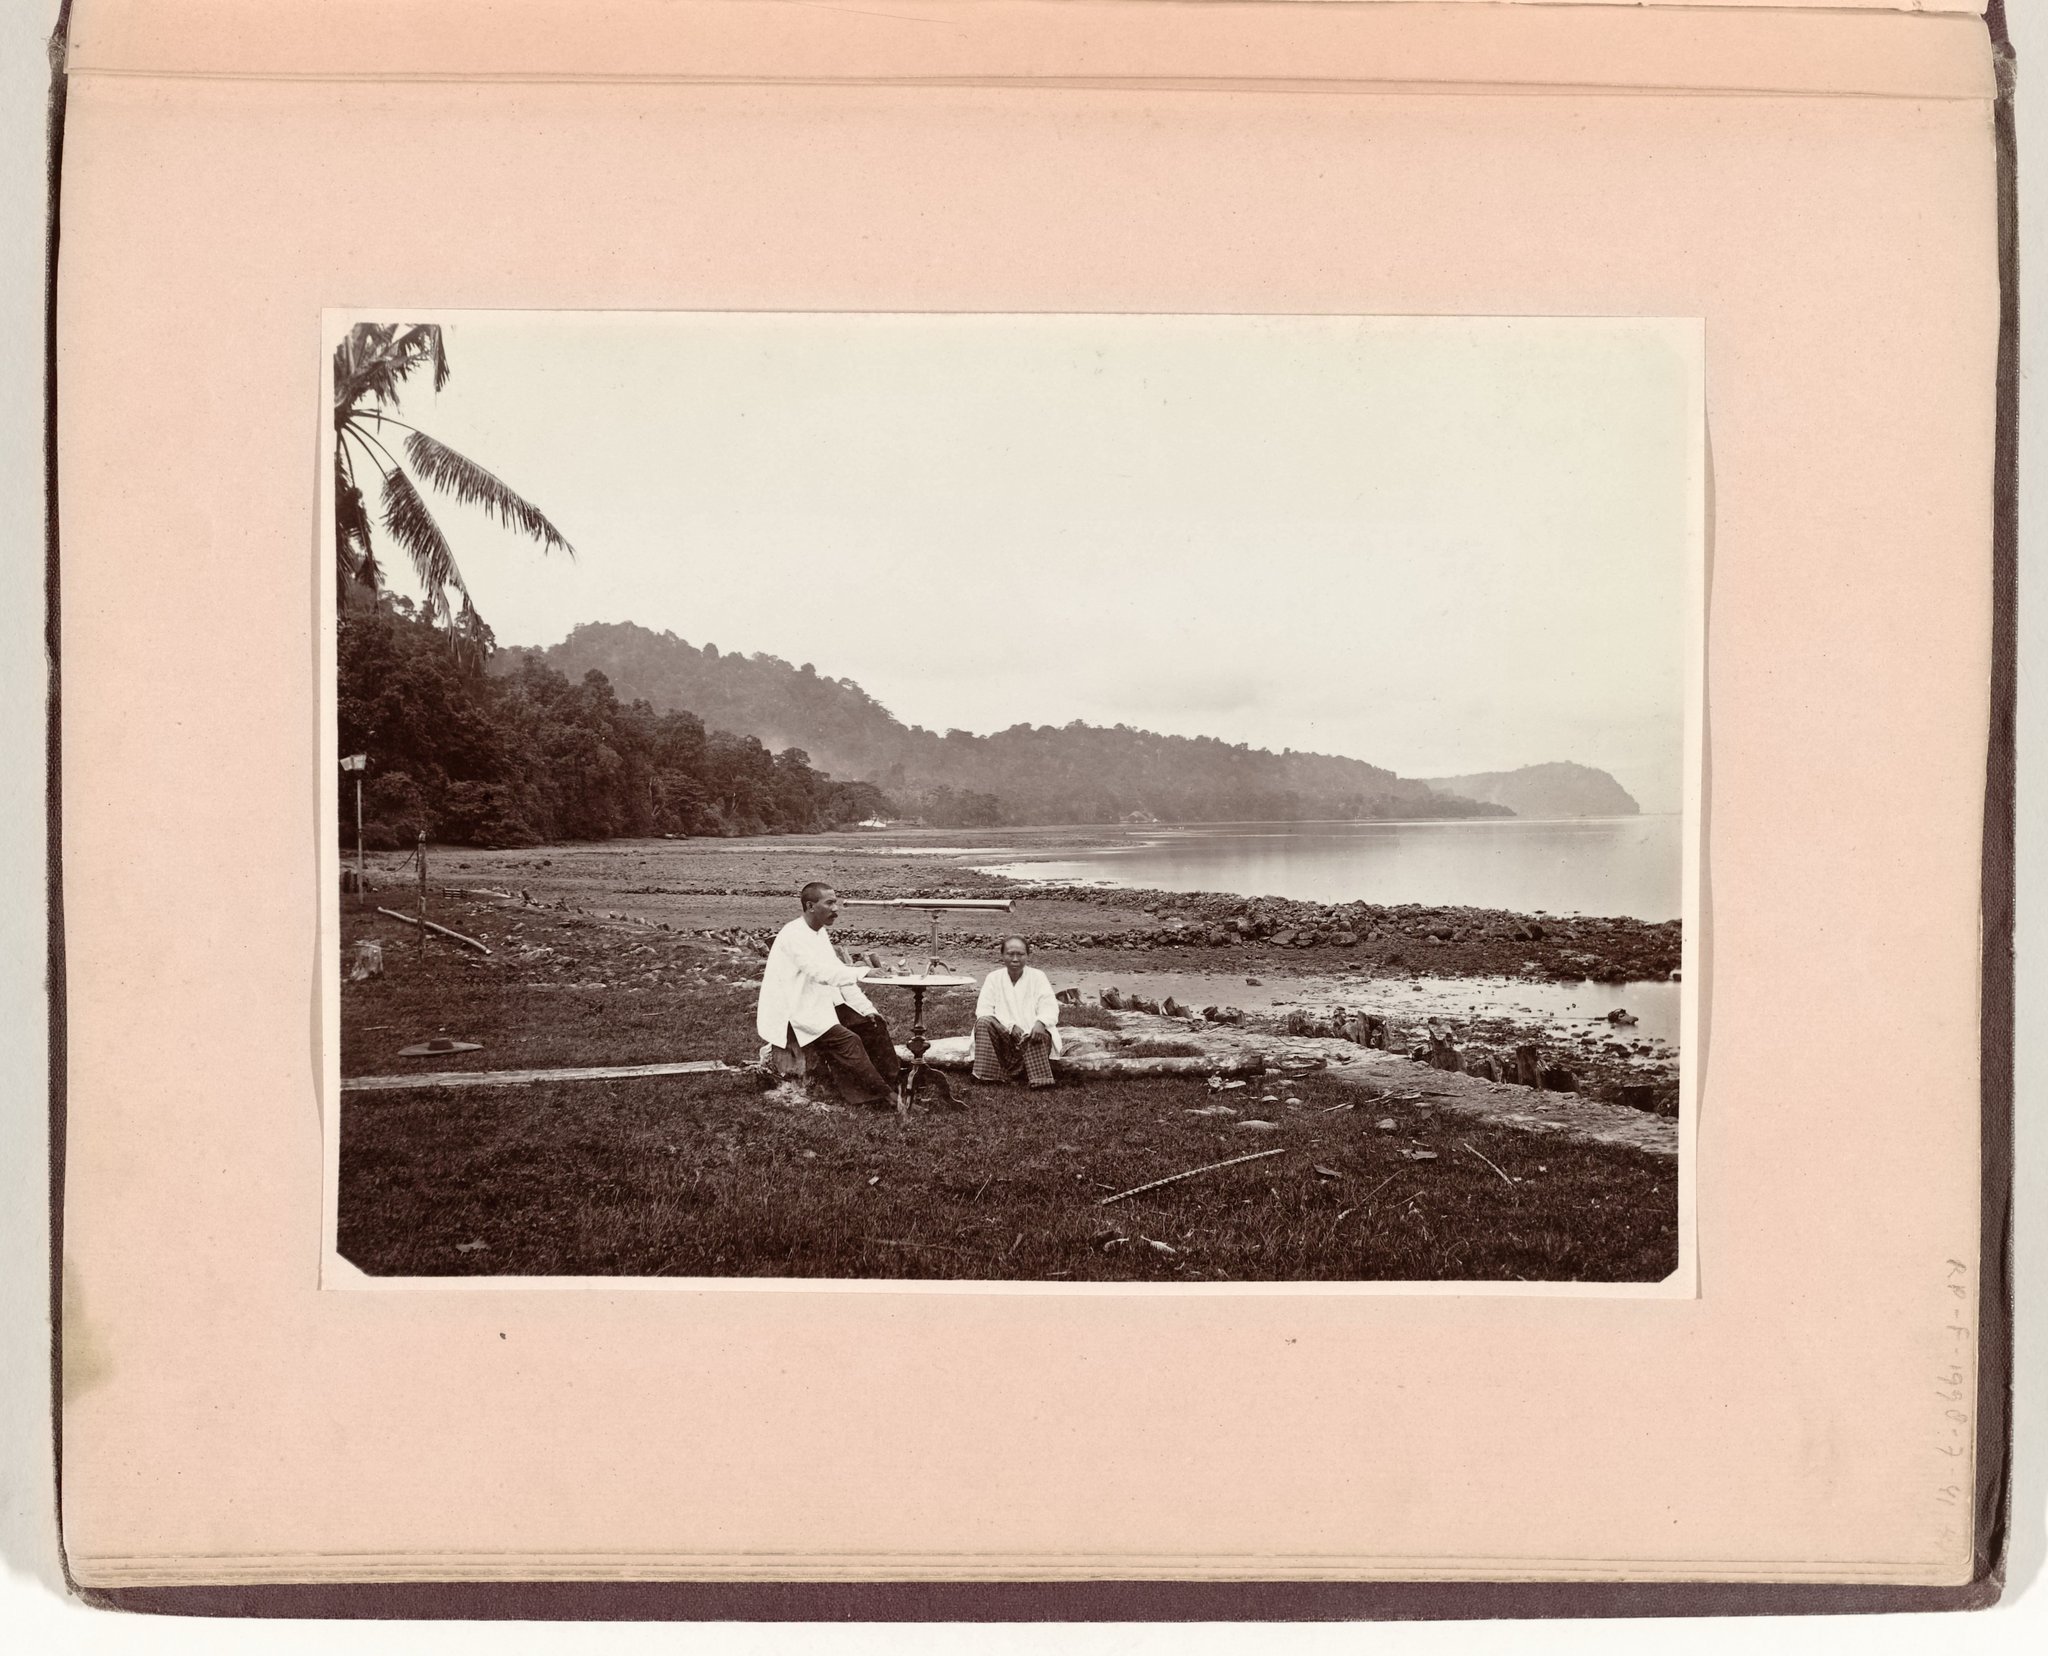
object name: photograph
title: Twee mannen met monoculair op het strand van Banda Besar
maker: c. dietrich (fotograaf)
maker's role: fotograaf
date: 1875-1890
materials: cardboard, paper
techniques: albumen print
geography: banda besar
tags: beach (+ landscape with figures, staffage)